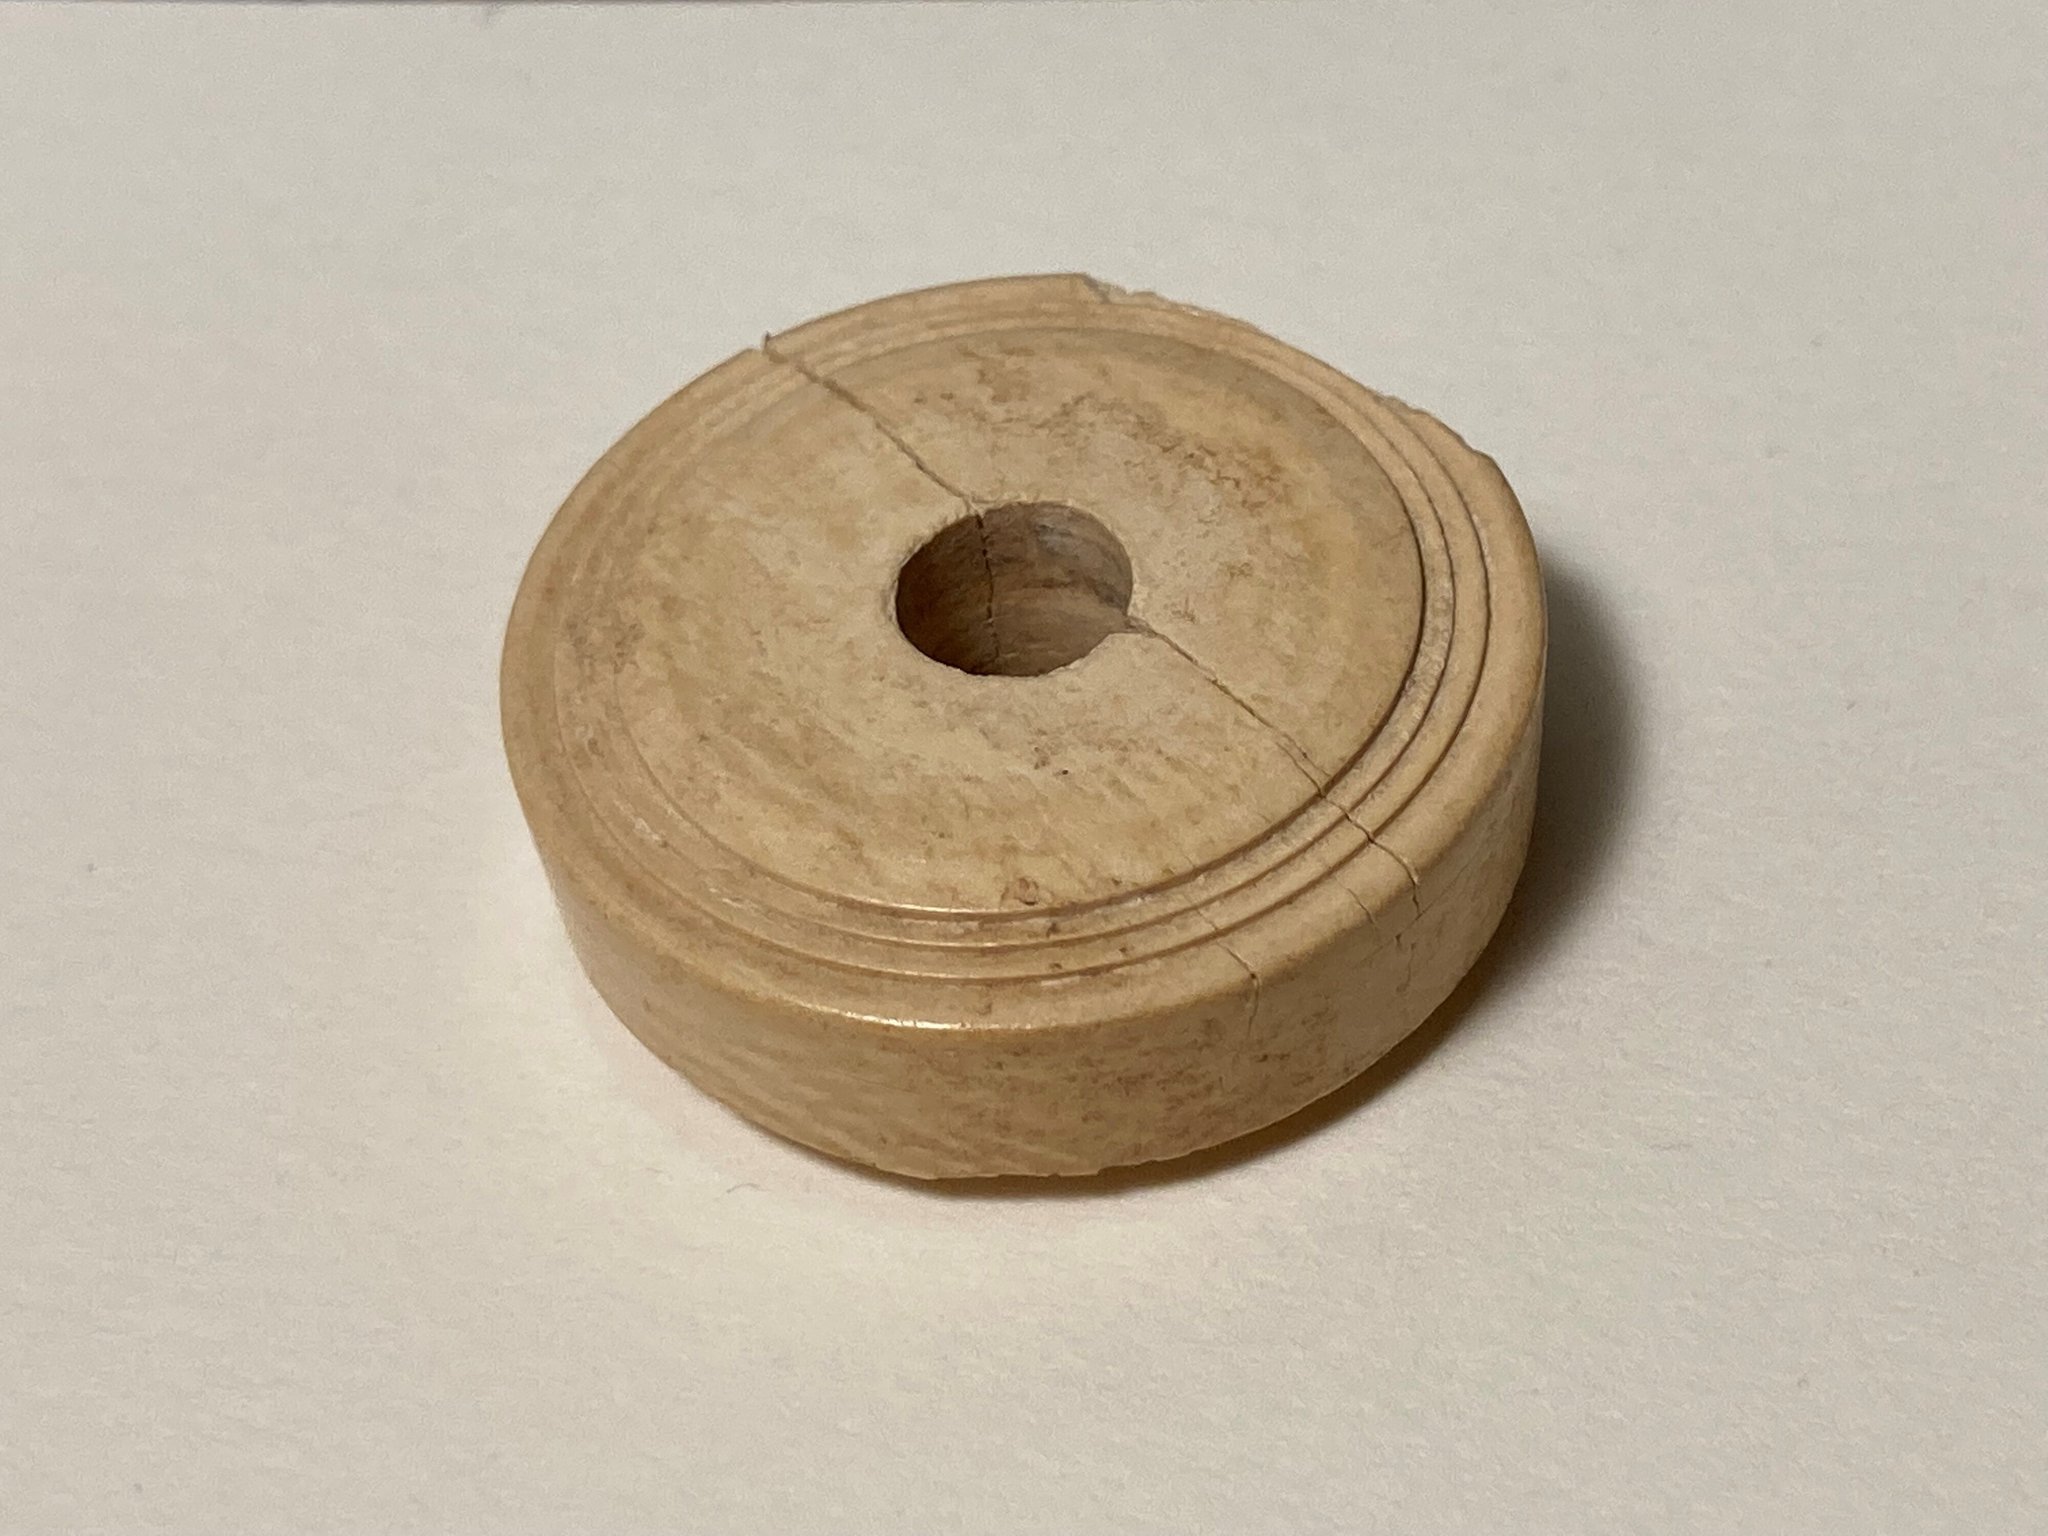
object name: bead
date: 801-1200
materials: bone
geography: iran